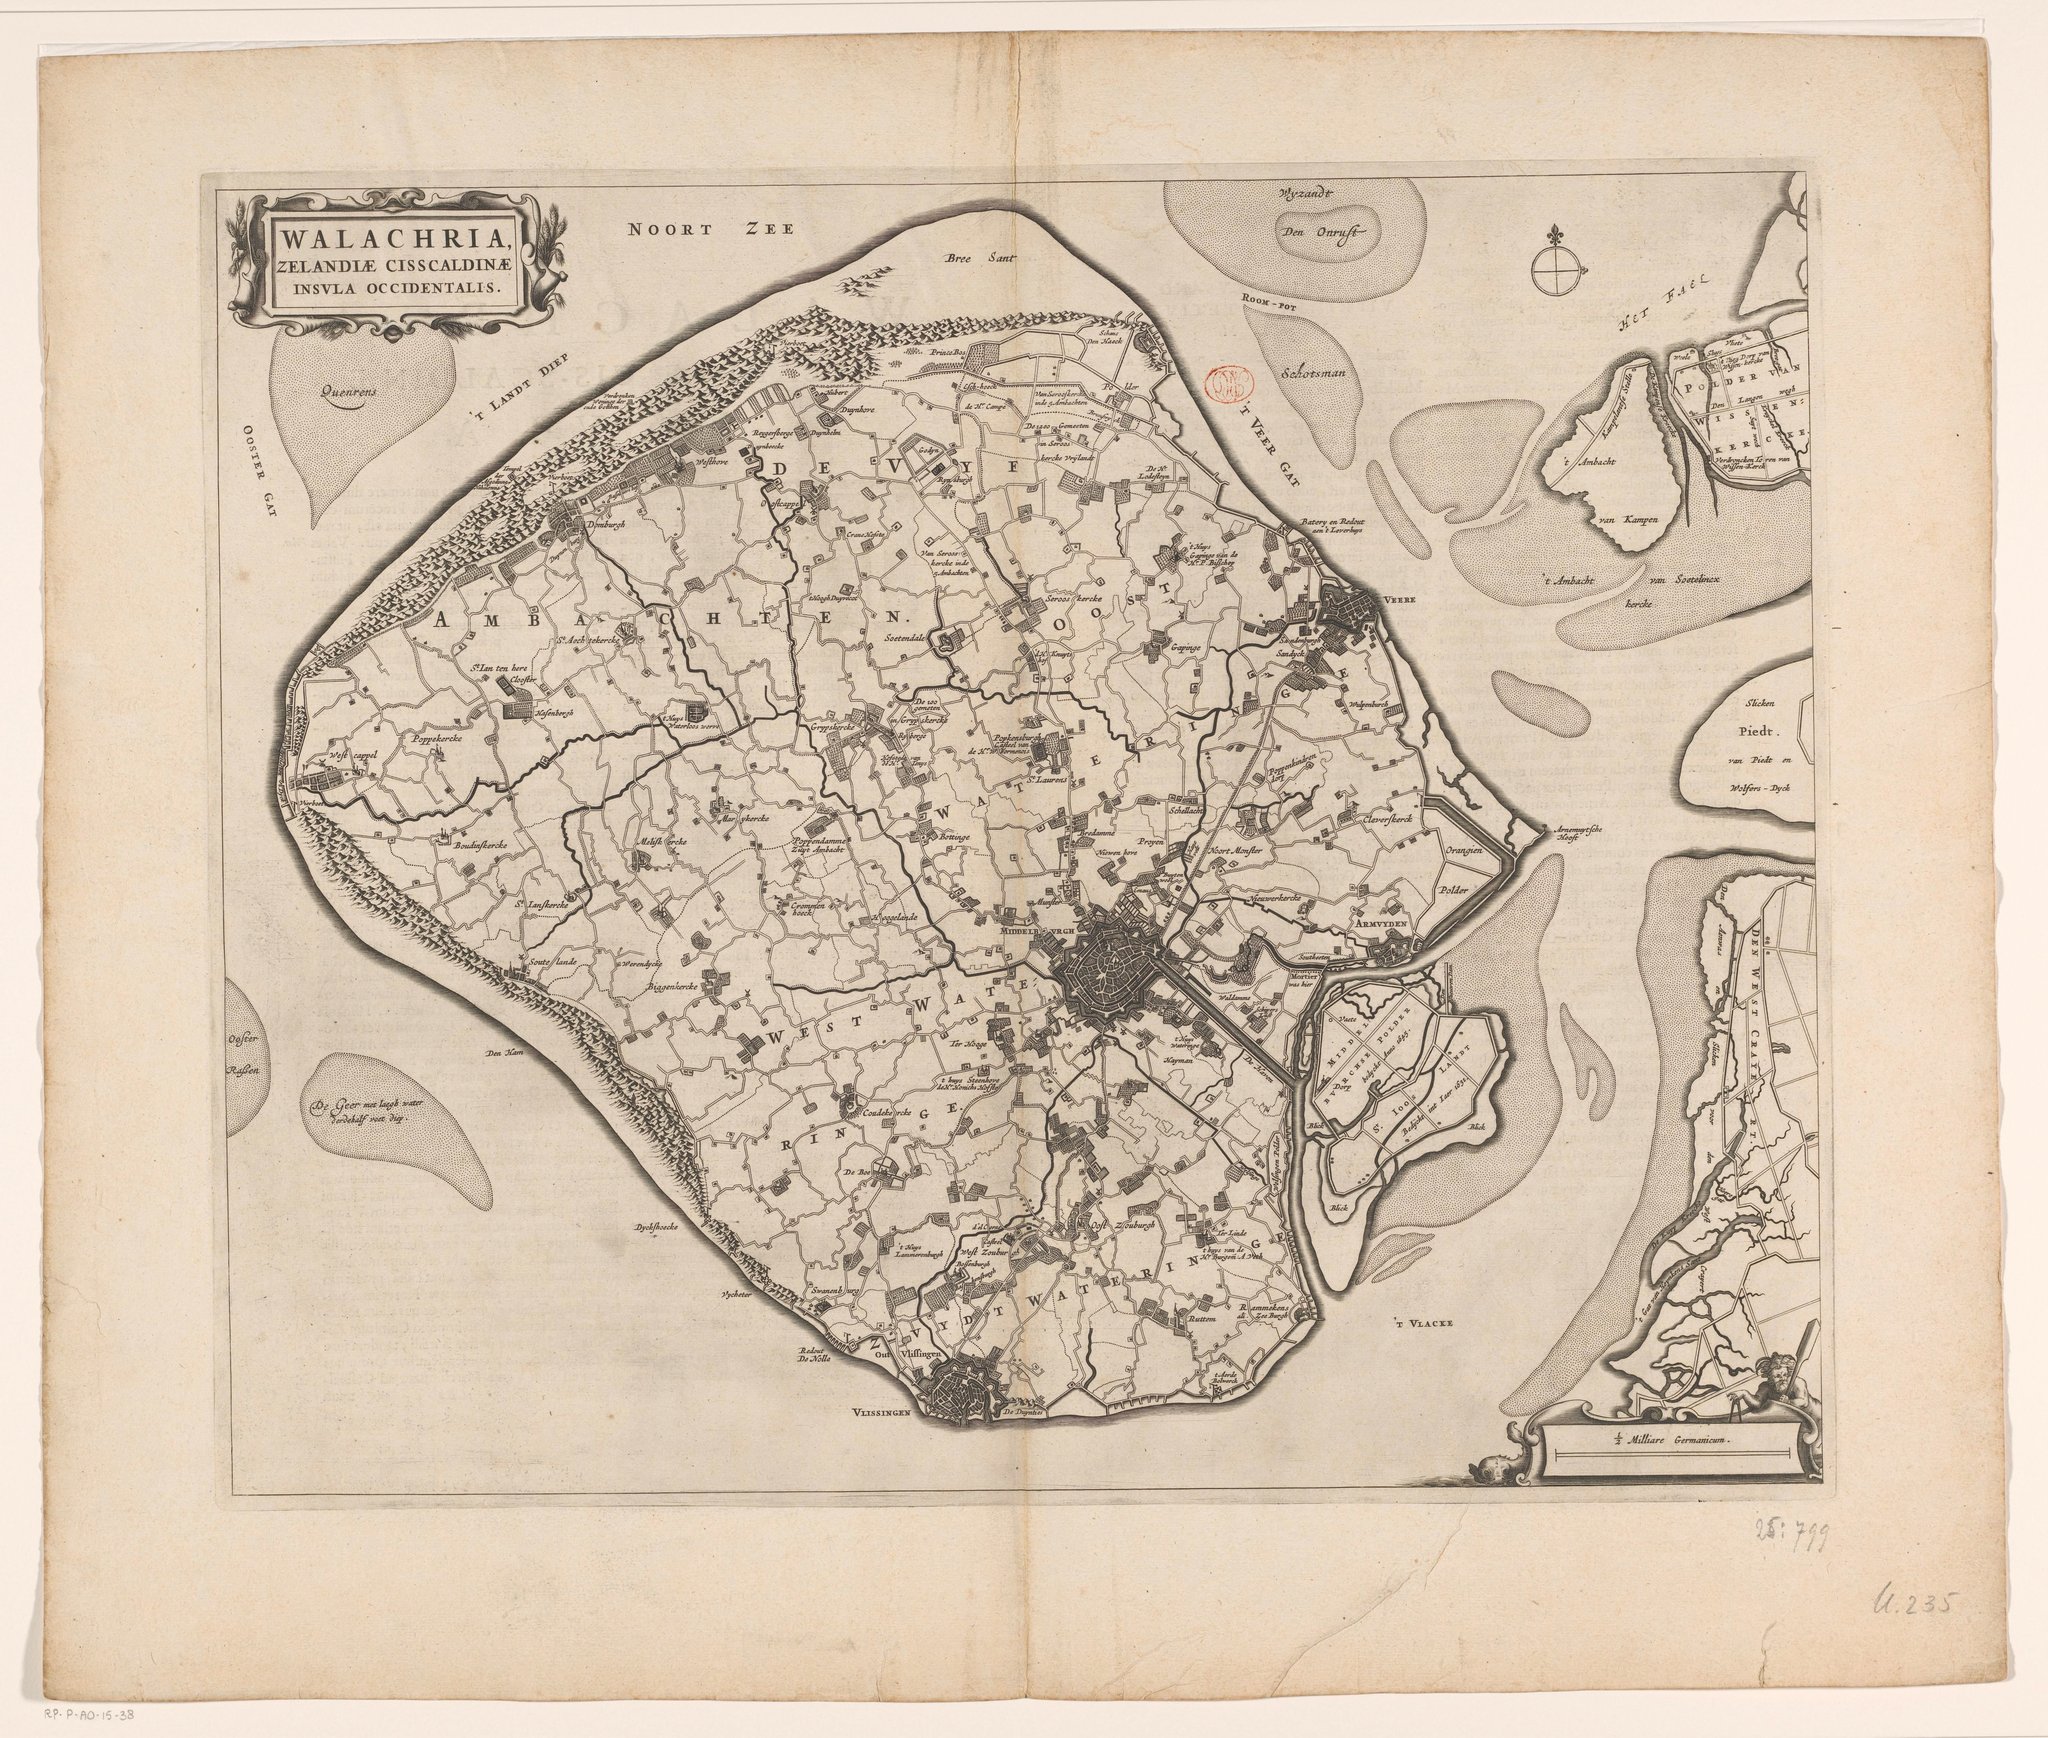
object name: print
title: Walachria, Zelandiae Cisscaldinae insula occidentalis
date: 1662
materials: paper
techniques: engraving, etching, letterpress printing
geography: amsterdam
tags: maps of separate countries or regions, river-gods, instruments used in geodesy, surveying instruments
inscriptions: collector's mark: Lugt 195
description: Prent gebruikt in: Blaeu, Johannes Willemszoon. Atlas Maior, sive Cosmographia Blaviana, qua solum, salum, coelum, accuratissime describuntur. Amsterdam: Johannes Willemszoon Blaeu, 1662, dl. 4.